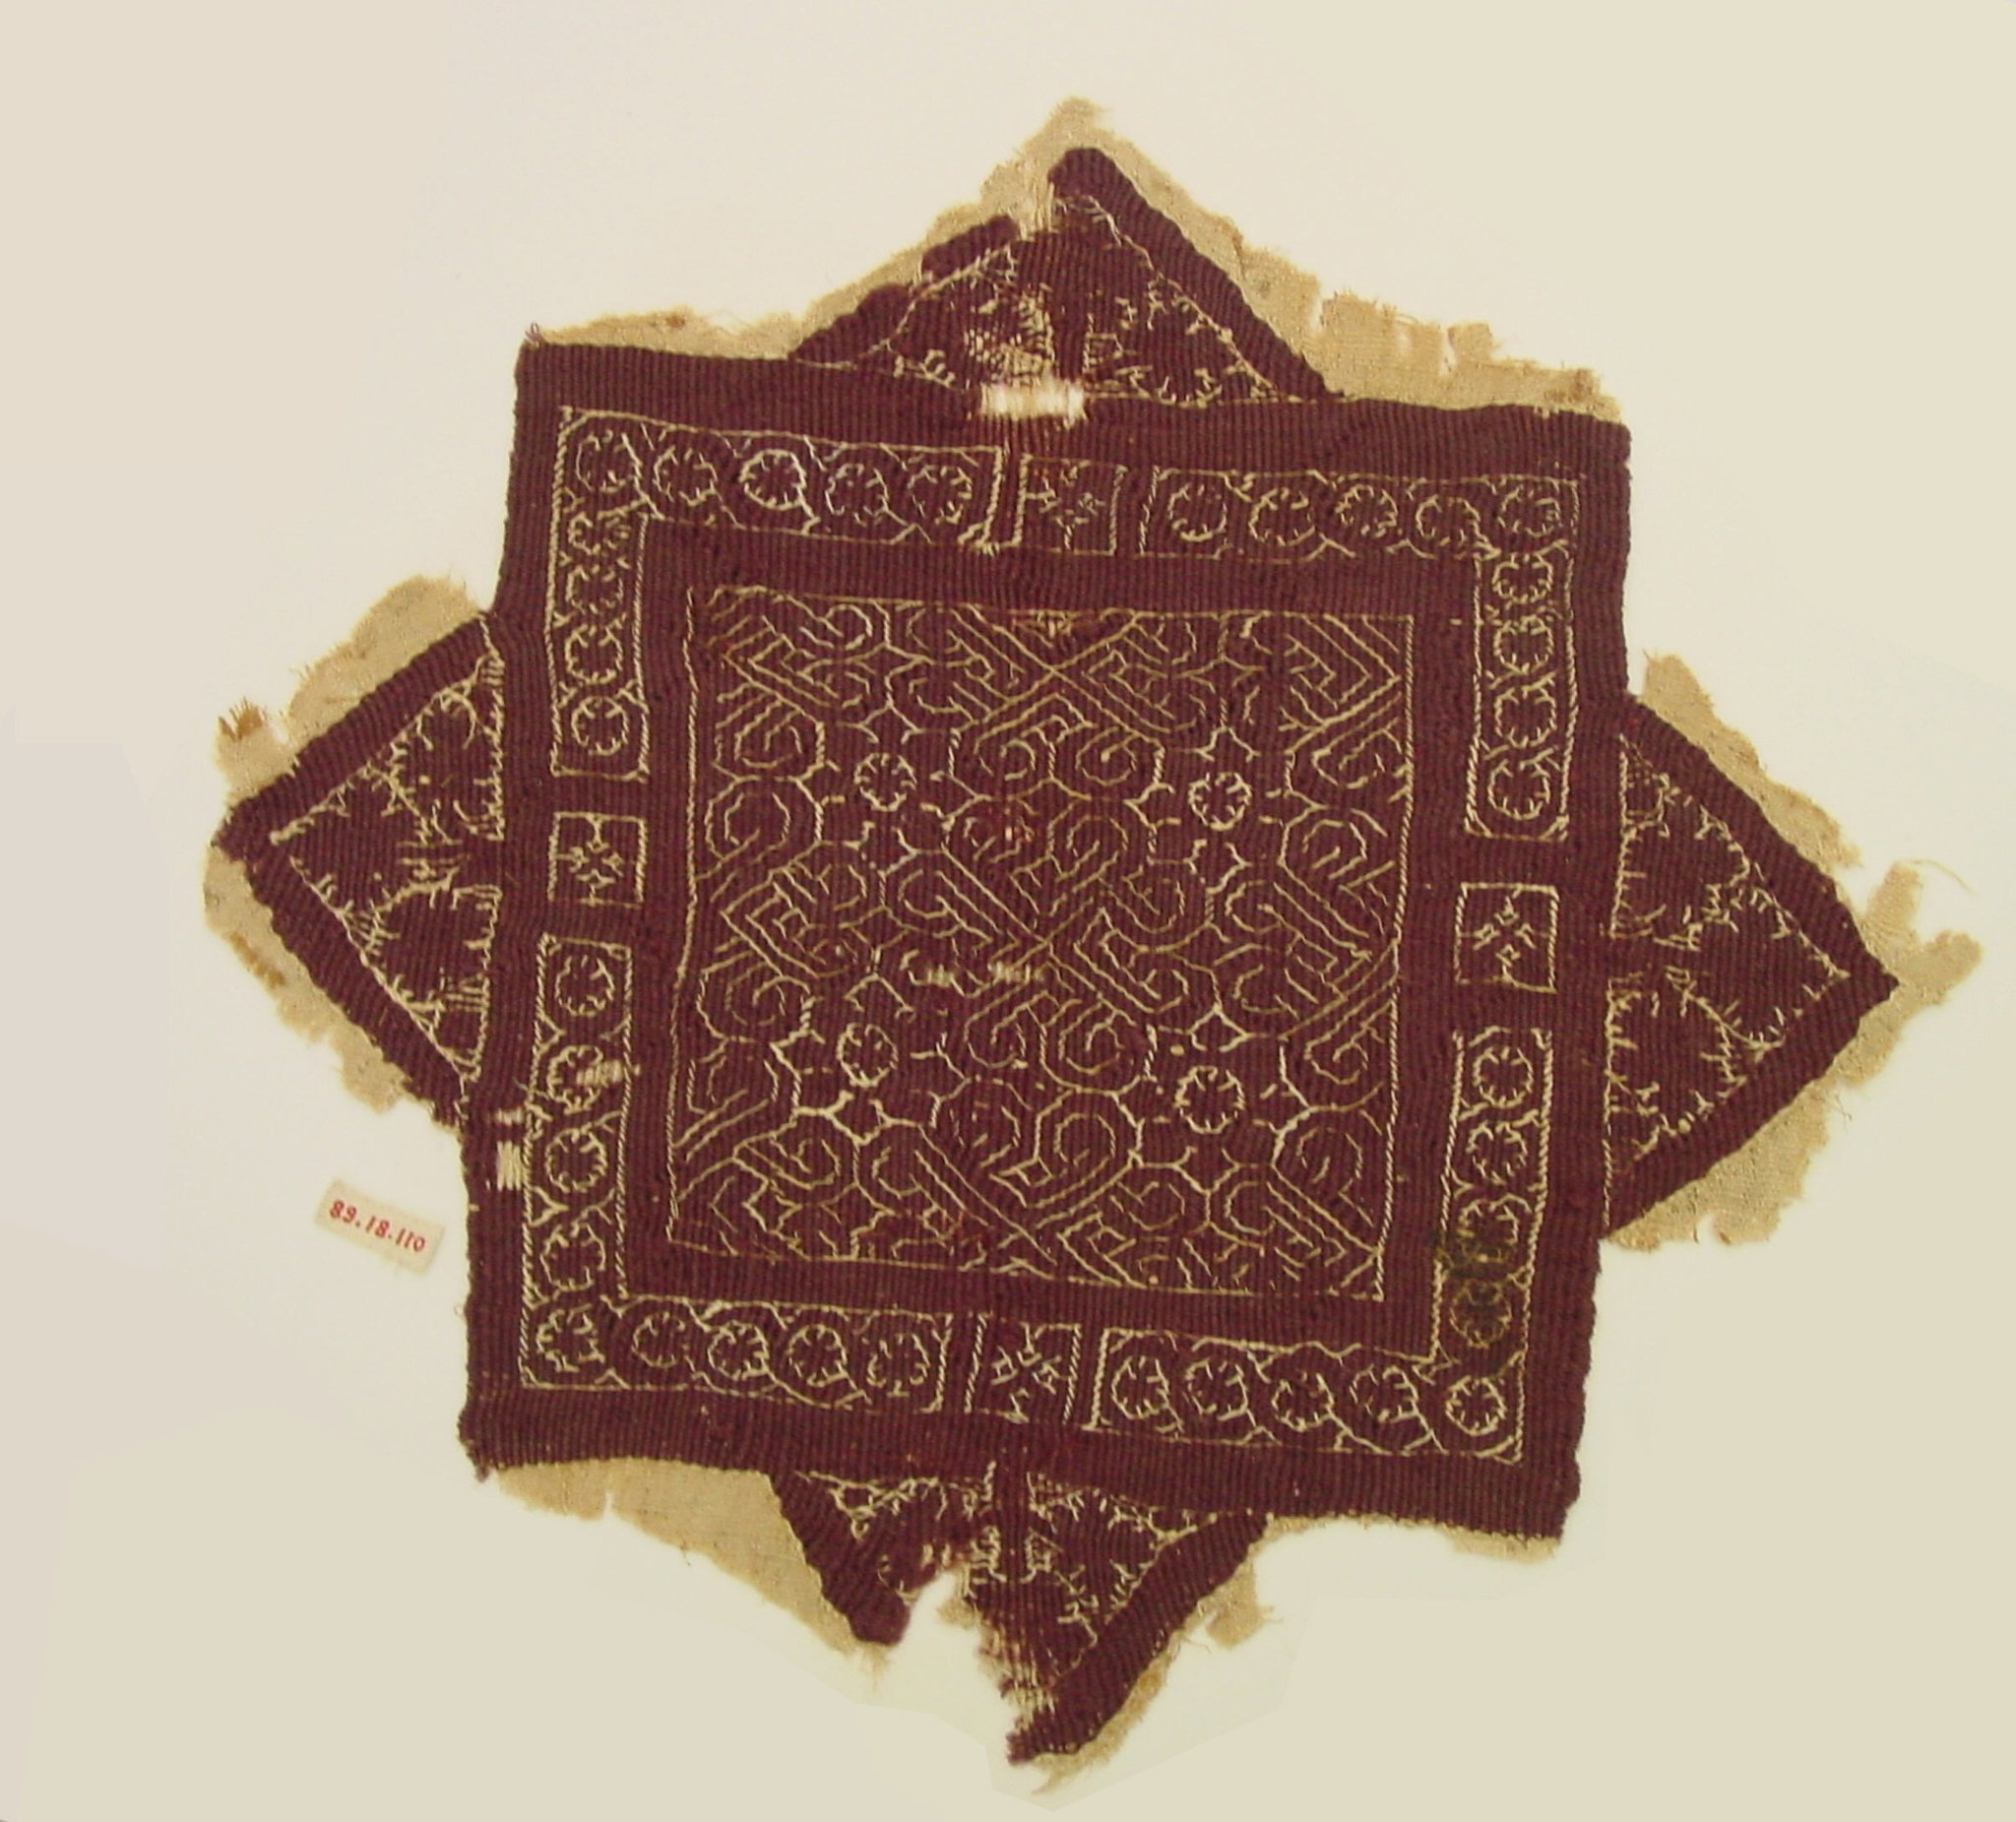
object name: textile fragment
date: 201-400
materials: linen, wool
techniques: weave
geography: egypt